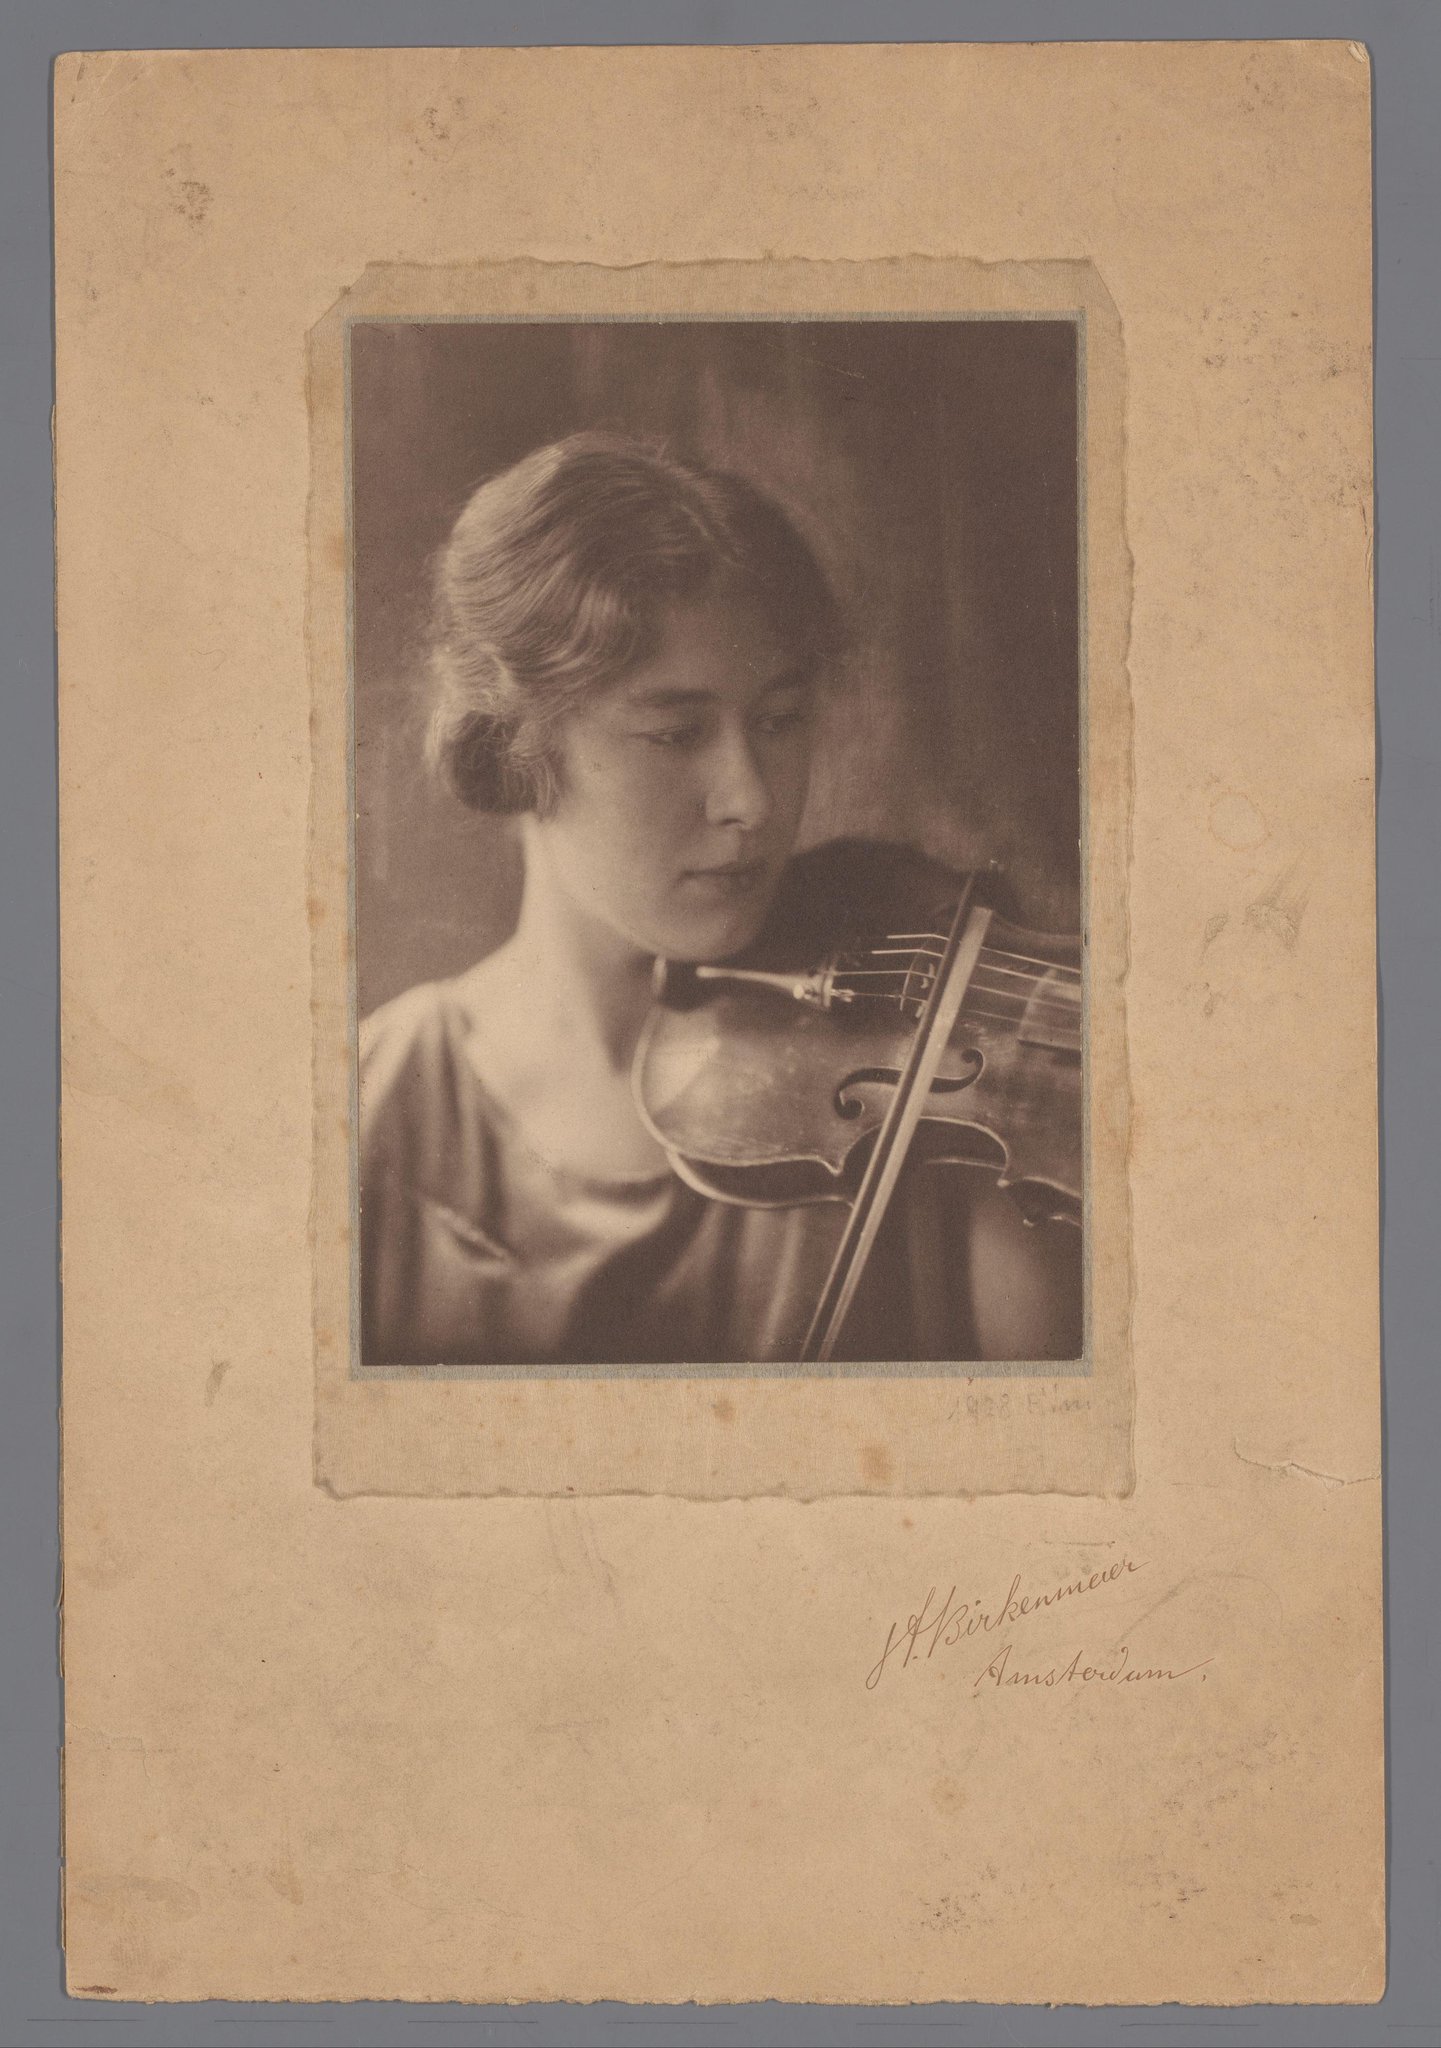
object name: photograph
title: Portret van een jonge vrouw met viool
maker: hermann birkenmeier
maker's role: fotograaf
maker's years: 1892-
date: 1928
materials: cardboard, photographic support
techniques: gelatin silver print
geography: amsterdam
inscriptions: date and inscription: ‘1928 film’, signature: ‘A. Birkenmeier//Amsterdam’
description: Portret van een jonge vrouw met een viool onder haar kin en donkerblond haar.